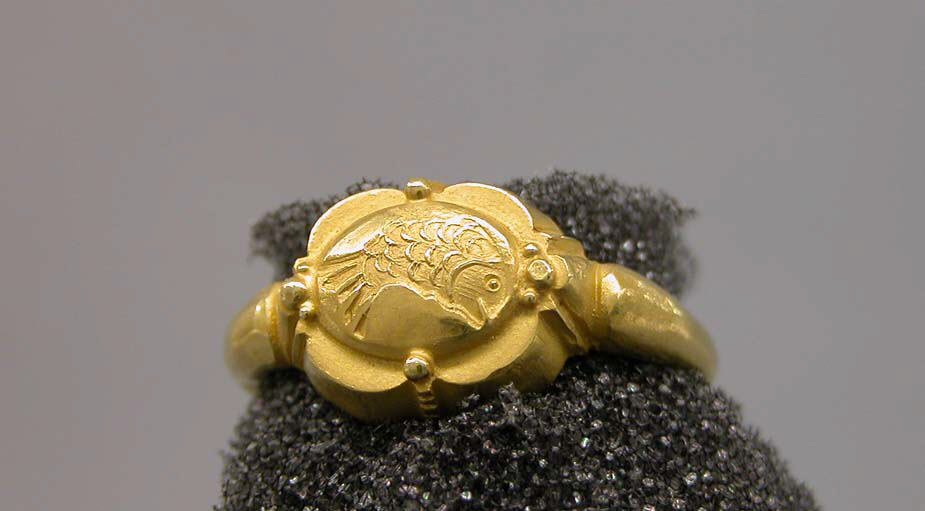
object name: ring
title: Ring with Quatrefoil-Shaped Bezel with Fish Motif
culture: indonesian, javanese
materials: gold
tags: fish